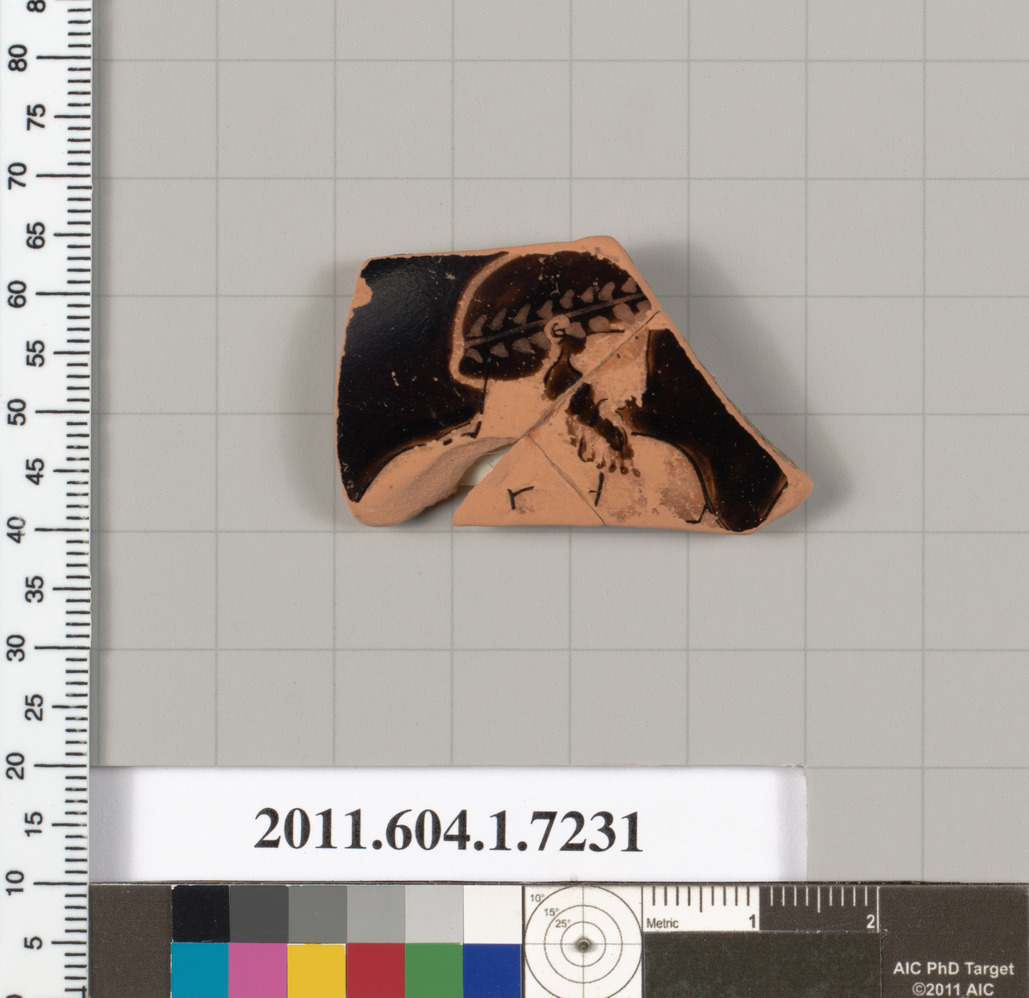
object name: kylix fragment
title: Terracotta fragment of a kylix (drinking cup)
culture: greek, attic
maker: makron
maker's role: artist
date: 500-480 BCE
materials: terracotta